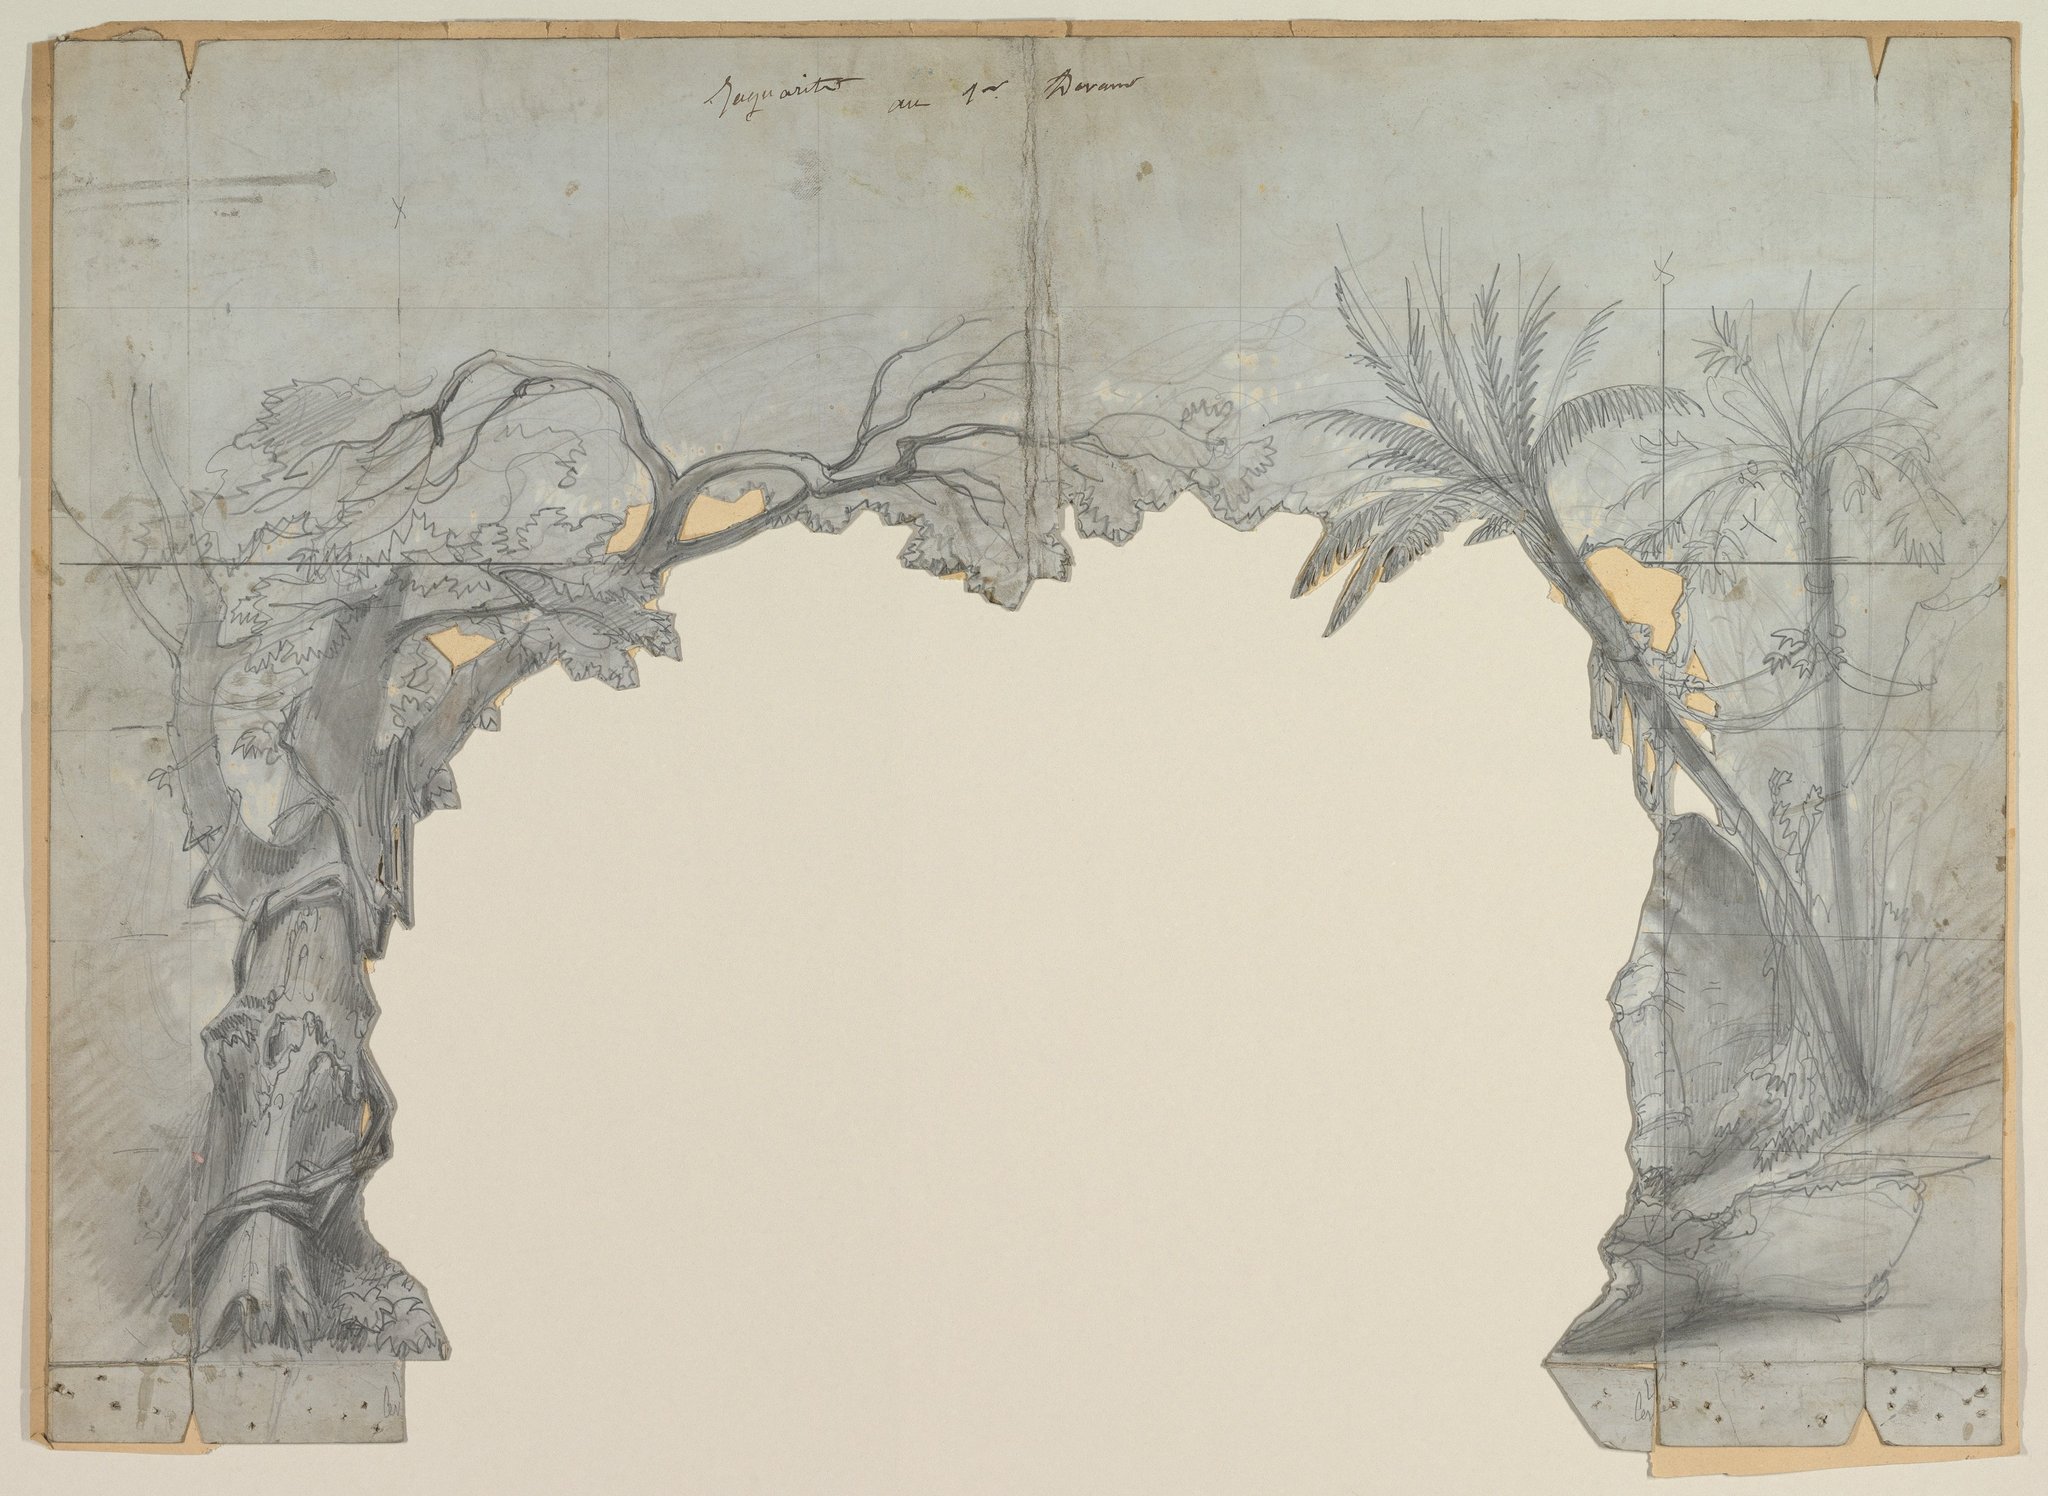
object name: drawing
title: Design for a Stage Set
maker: eugène cicéri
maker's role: artist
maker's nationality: french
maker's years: 1813-1890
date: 1825-1890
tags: trees,stage design